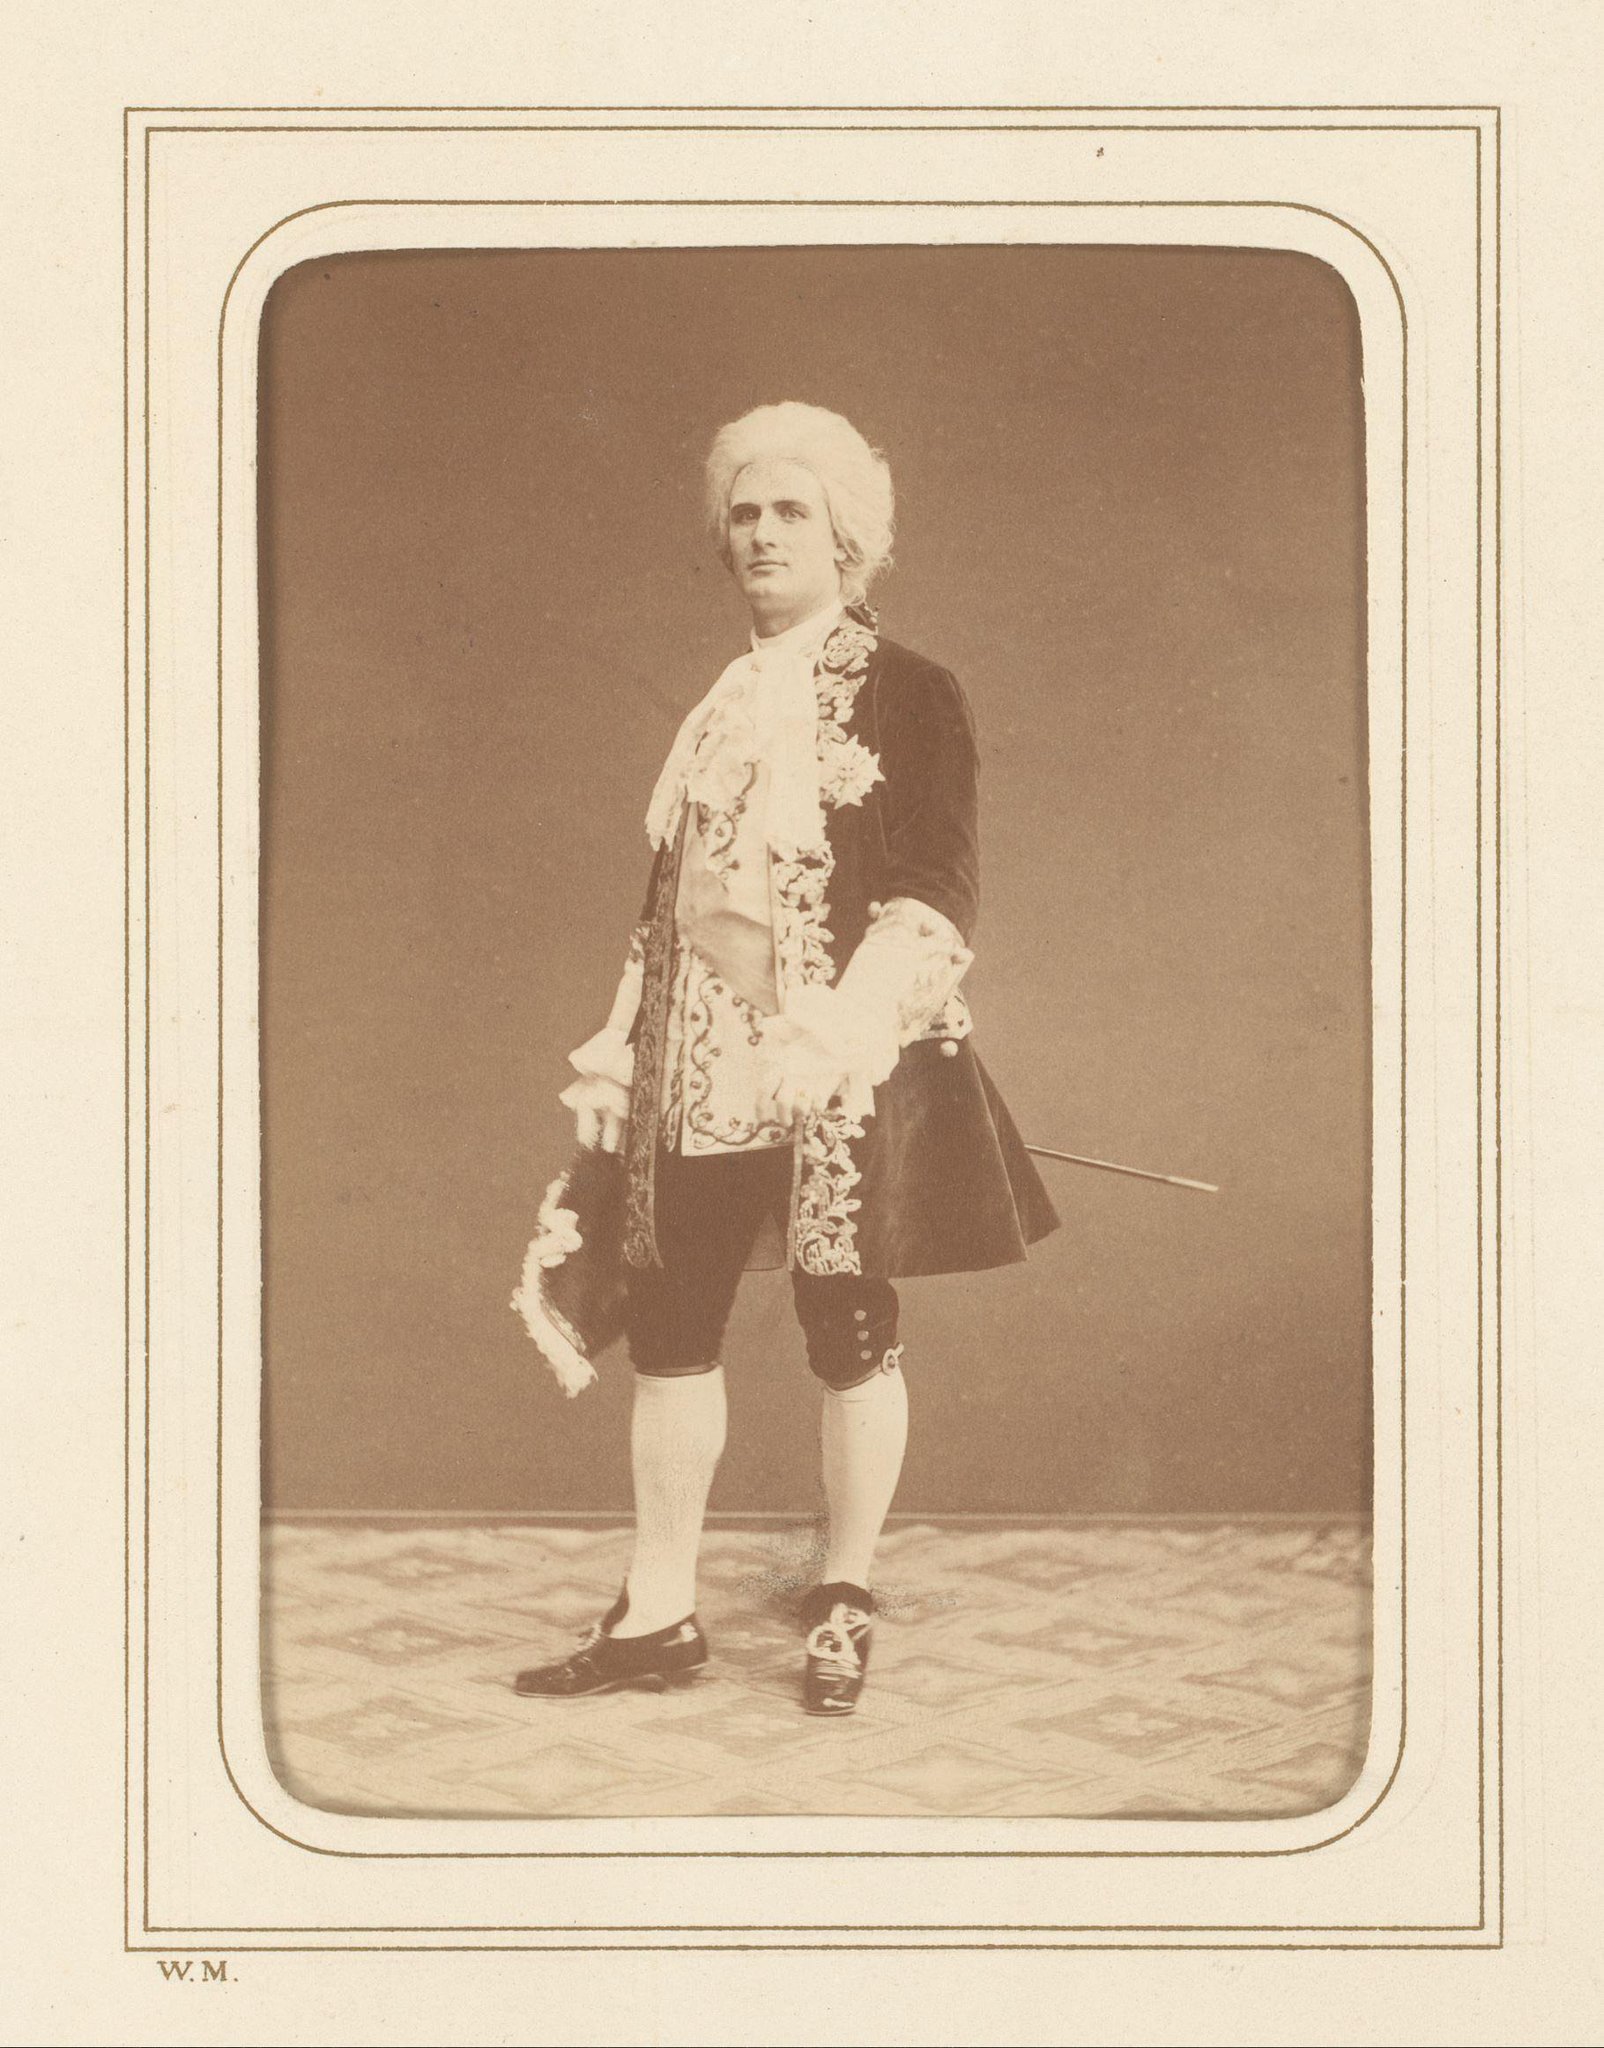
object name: cabinet photograph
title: Portret van Victor Hartman in kostuum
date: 1867-1877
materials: cardboard, photographic support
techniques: albumen print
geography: stockholm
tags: stage costume, historical persons, portrait of actor, actress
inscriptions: annotation: ‘Victor Hartman/ 1839-1898’, inscription: ‘GUST. JOOP & COMPs/ Fotografi Atelier/ STOCKHOLM/ Wahrendorffsgatan No. 10/ 3 tr. upp.’